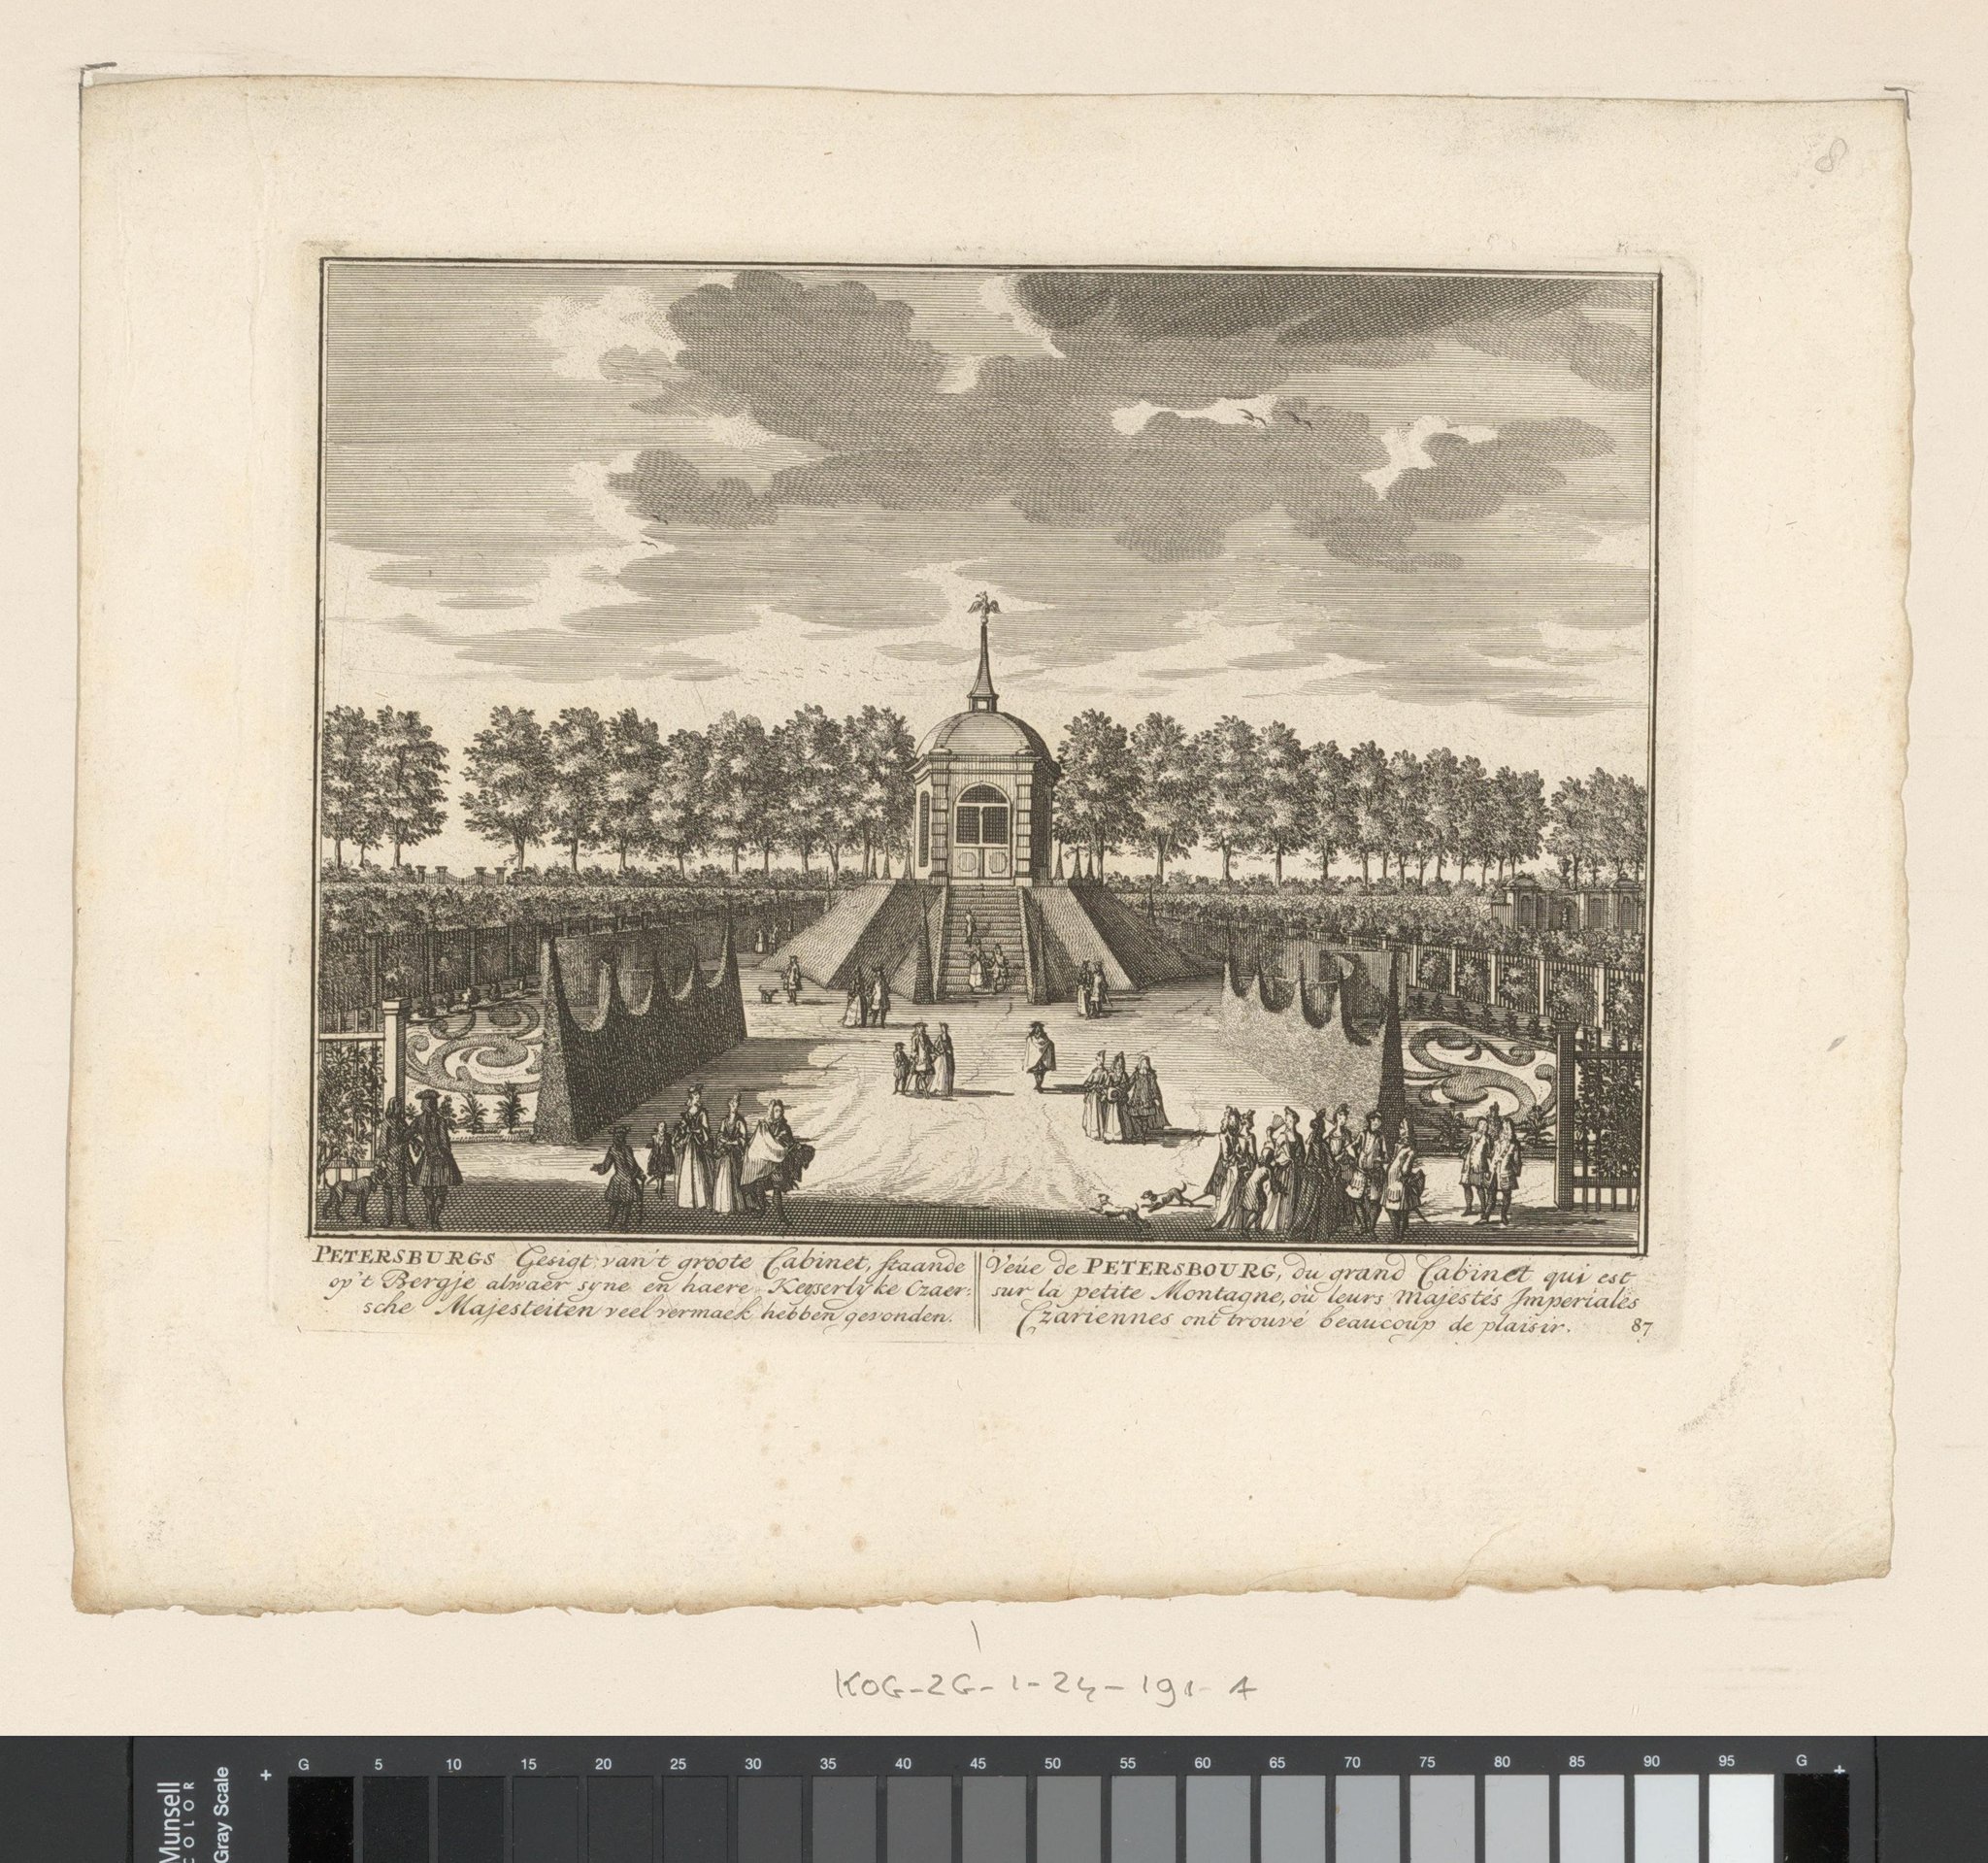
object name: print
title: Gezicht op het cabinet in de tuin van buitenplaats Petersburg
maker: hendrik de leth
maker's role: draughtsman, print maker, publisher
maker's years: 1703-1766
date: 1729-1732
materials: paper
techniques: engraving, etching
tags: french or architectonic garden; formal garden, garden buildings, country-house, nederhorst den berg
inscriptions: collector's mark: Lugt 1641, stamp, stamp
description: Prent mogelijk uit: Brouërius van Nidek, Matthaeus. Het zegepralend Kennemerland, vertoond in 100 heerlyke gezichten. Amsterdam: Jan Roman, s.a. Of uit: Brouërius van Nidek, Matthaeus. Het zegepralend Kennemerland, vertoond in veele heerlyke gezichten. Amsterdam: Andries en Hendrik de Leth, s.a [1729-1732]. Of uit: Brouërius van Nidek, Matthaeus. Het zegepralend Kennemerland, vertoond in veele heerlyke gezichten. Amsterdam: Jan Roman, s.a.